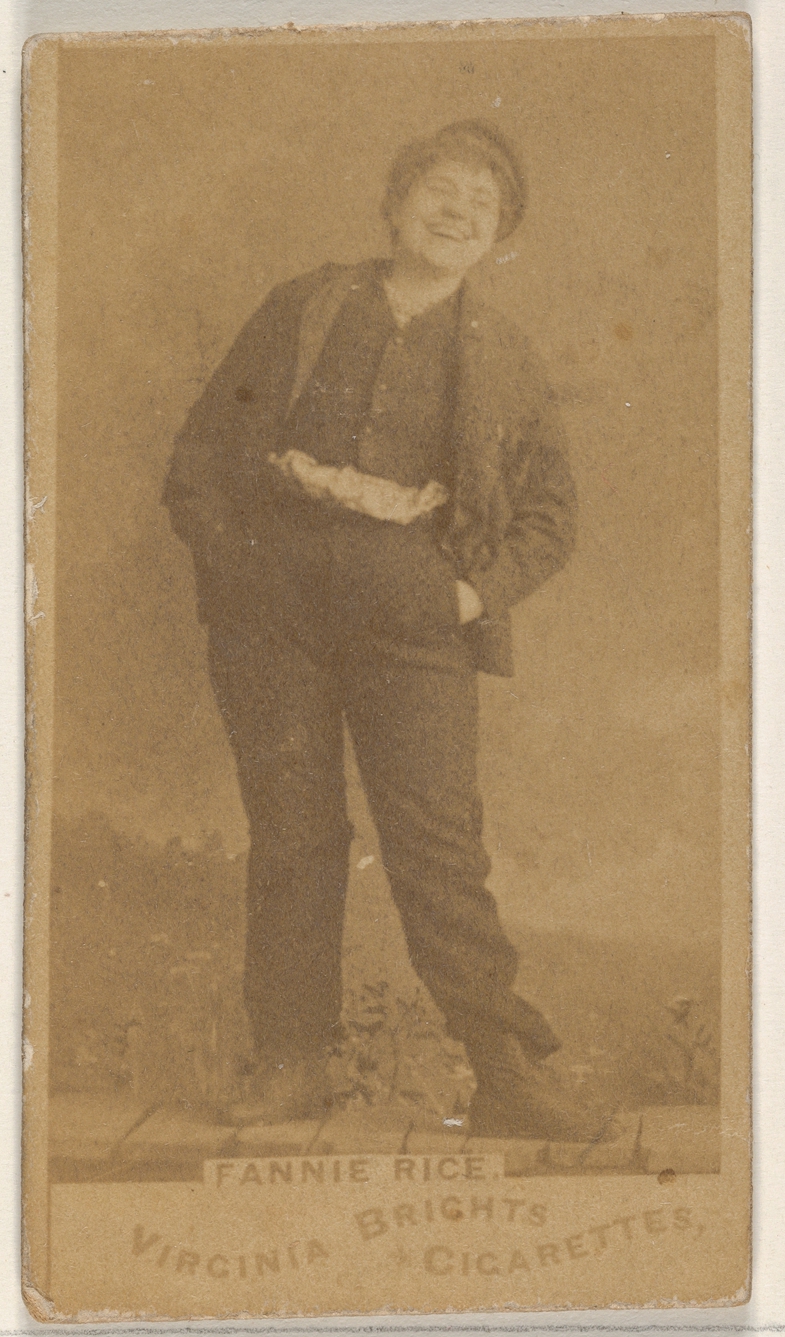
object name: photograph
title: Fannie Rice, from the Actors and Actresses series (N45, Type 1) for Virginia Brights Cigarettes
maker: allen & ginter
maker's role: publisher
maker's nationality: american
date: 1888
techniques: albumen silver print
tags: portraits,women,actresses